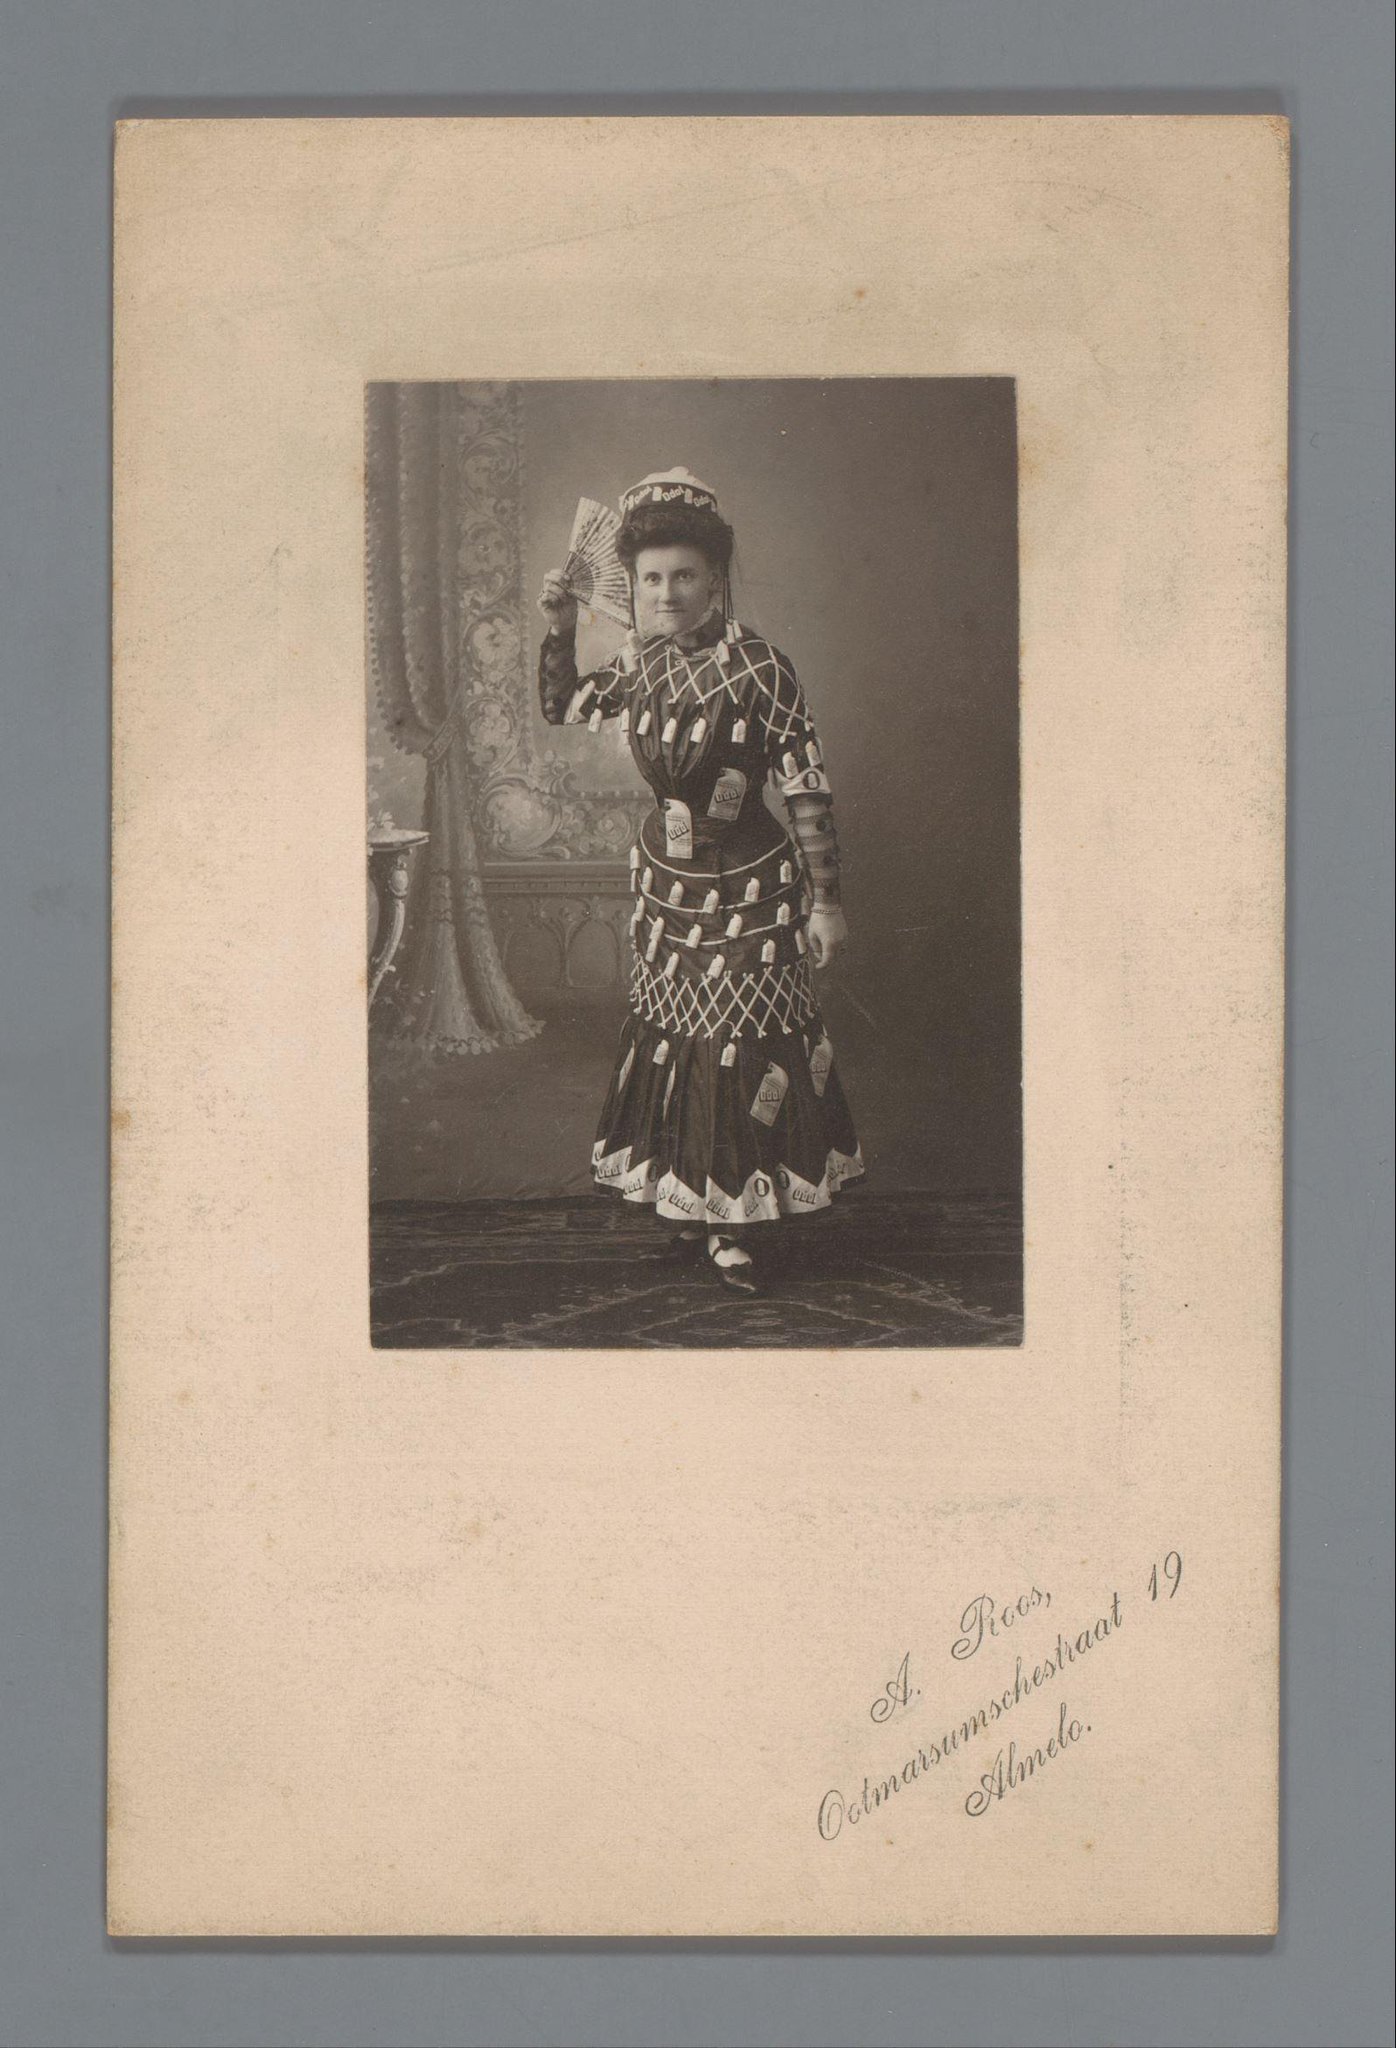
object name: photograph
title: Portret van een onbekende vrouw in carnavalskostuum met Odolverpakkingen en een waaier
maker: aart roos (fotograaf)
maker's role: fotograaf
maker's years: 1870-1959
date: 1902-1910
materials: cardboard, photographic support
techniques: gelatin silver print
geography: almelo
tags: festivities (+ costume party ~ festive activities), adult woman, fan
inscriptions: inscription: ‘Herrinering aan een onvergetelijken Carnaval door gemaakt van 6 - 10 febrie 1910 in Nijmegen met Teun - Dick - Mies - Cor - Clärchen - Bé - Henk - Beb Je Clärchen’